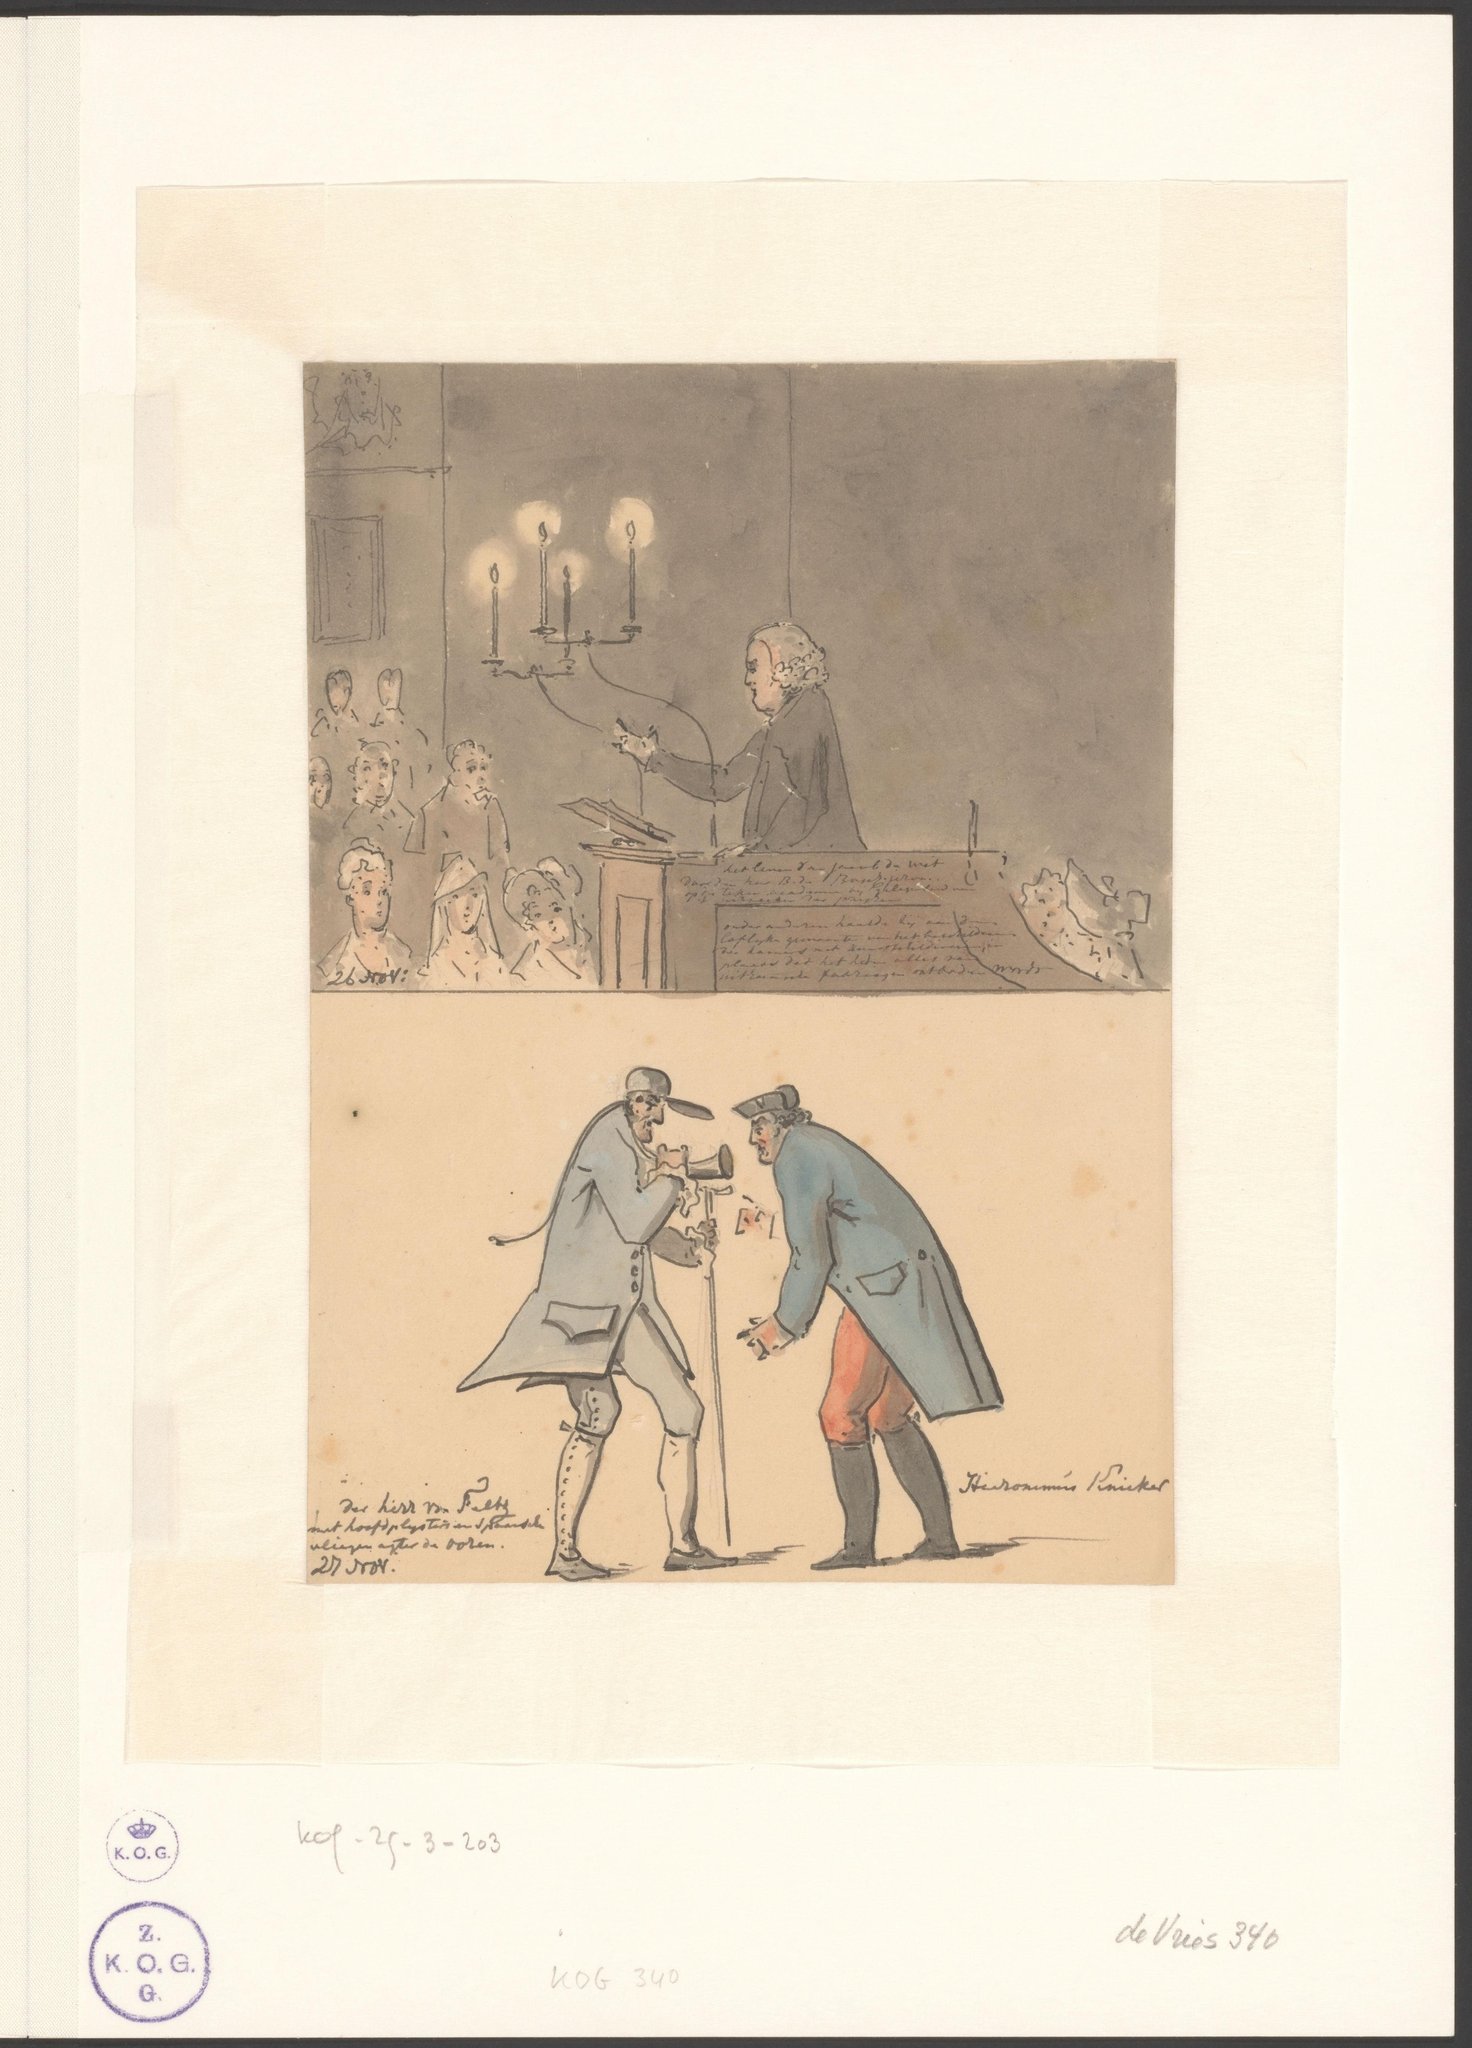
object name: drawing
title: Voordracht van Bernardus de Bosch over Jacob de Wit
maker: christiaan andriessen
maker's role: draughtsman, print maker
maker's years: 1775-1846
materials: ink, paper, pencil, watercolor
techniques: brush, pen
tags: painter, jacob de wit, history of art, opera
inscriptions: signature: ‘J Andriessen’, inscription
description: Twee voorstellingen op een bladzijde. Bovenaan een voordracht van Bernardus de Bosch over Jacob de Wit op de Tekenacademie. Onderaan twee figuren uit de opera Hieronymus Knicker.